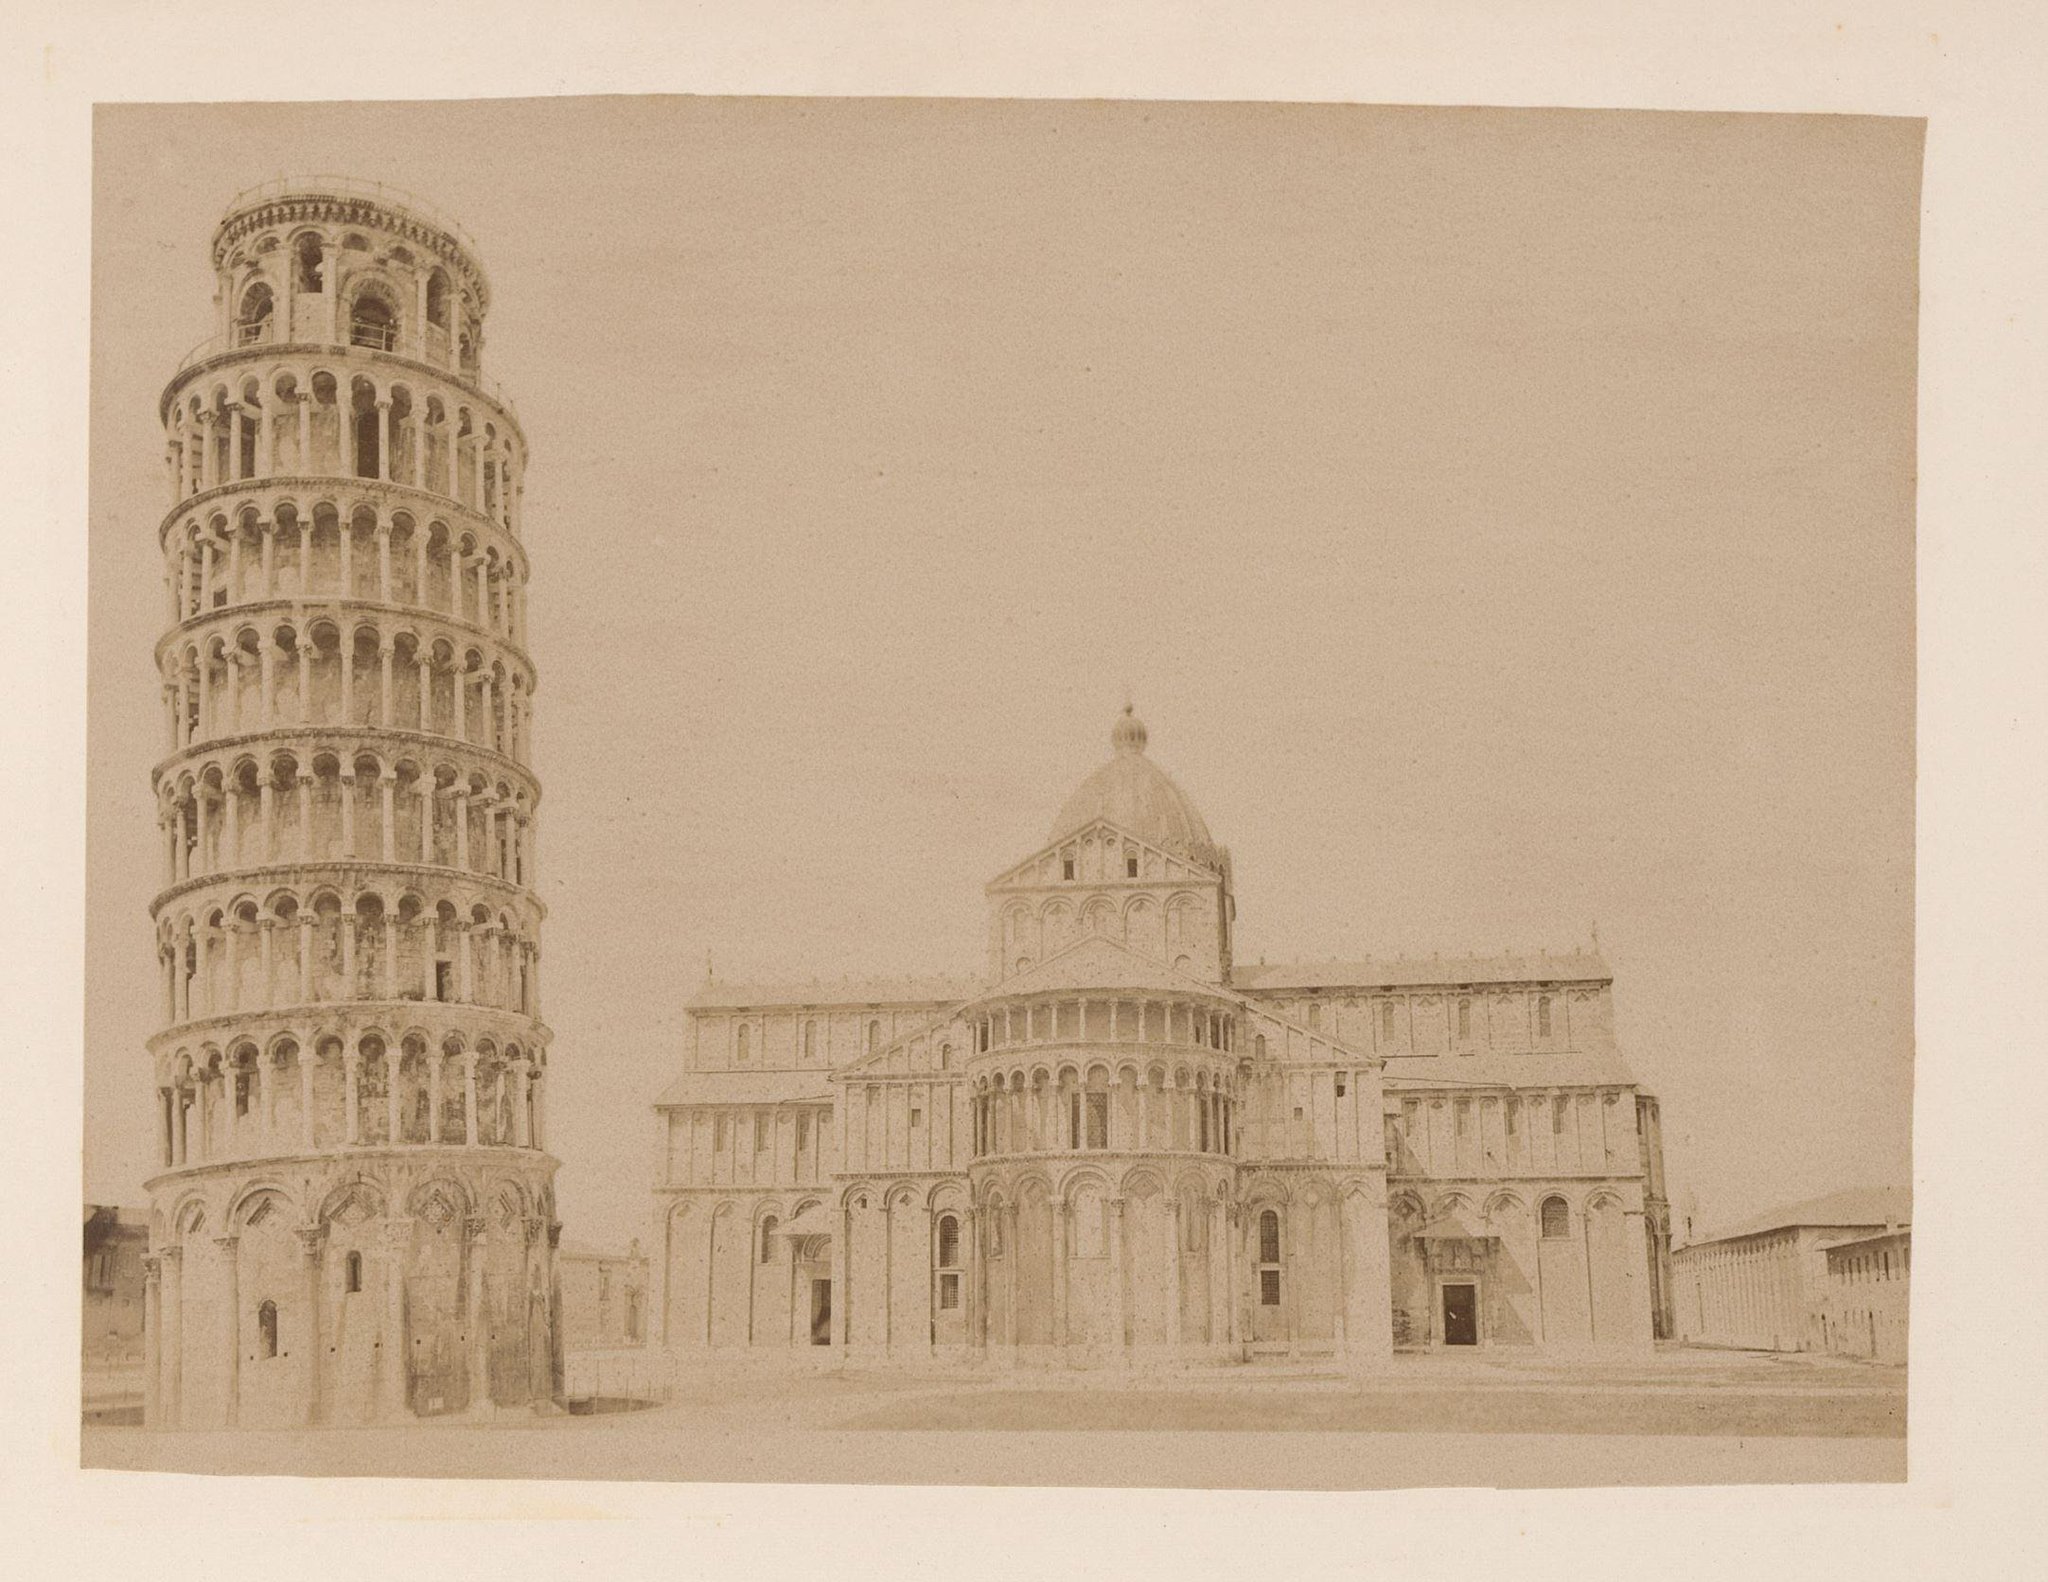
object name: album leaf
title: Gezicht op het Baptisterium, de kathedraal en de Toren van Pisa, Italië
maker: Anonymous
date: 1860-1880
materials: paper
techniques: albumen print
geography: pisa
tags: square, place, circus, etc., church (exterior), tower (of house or building)